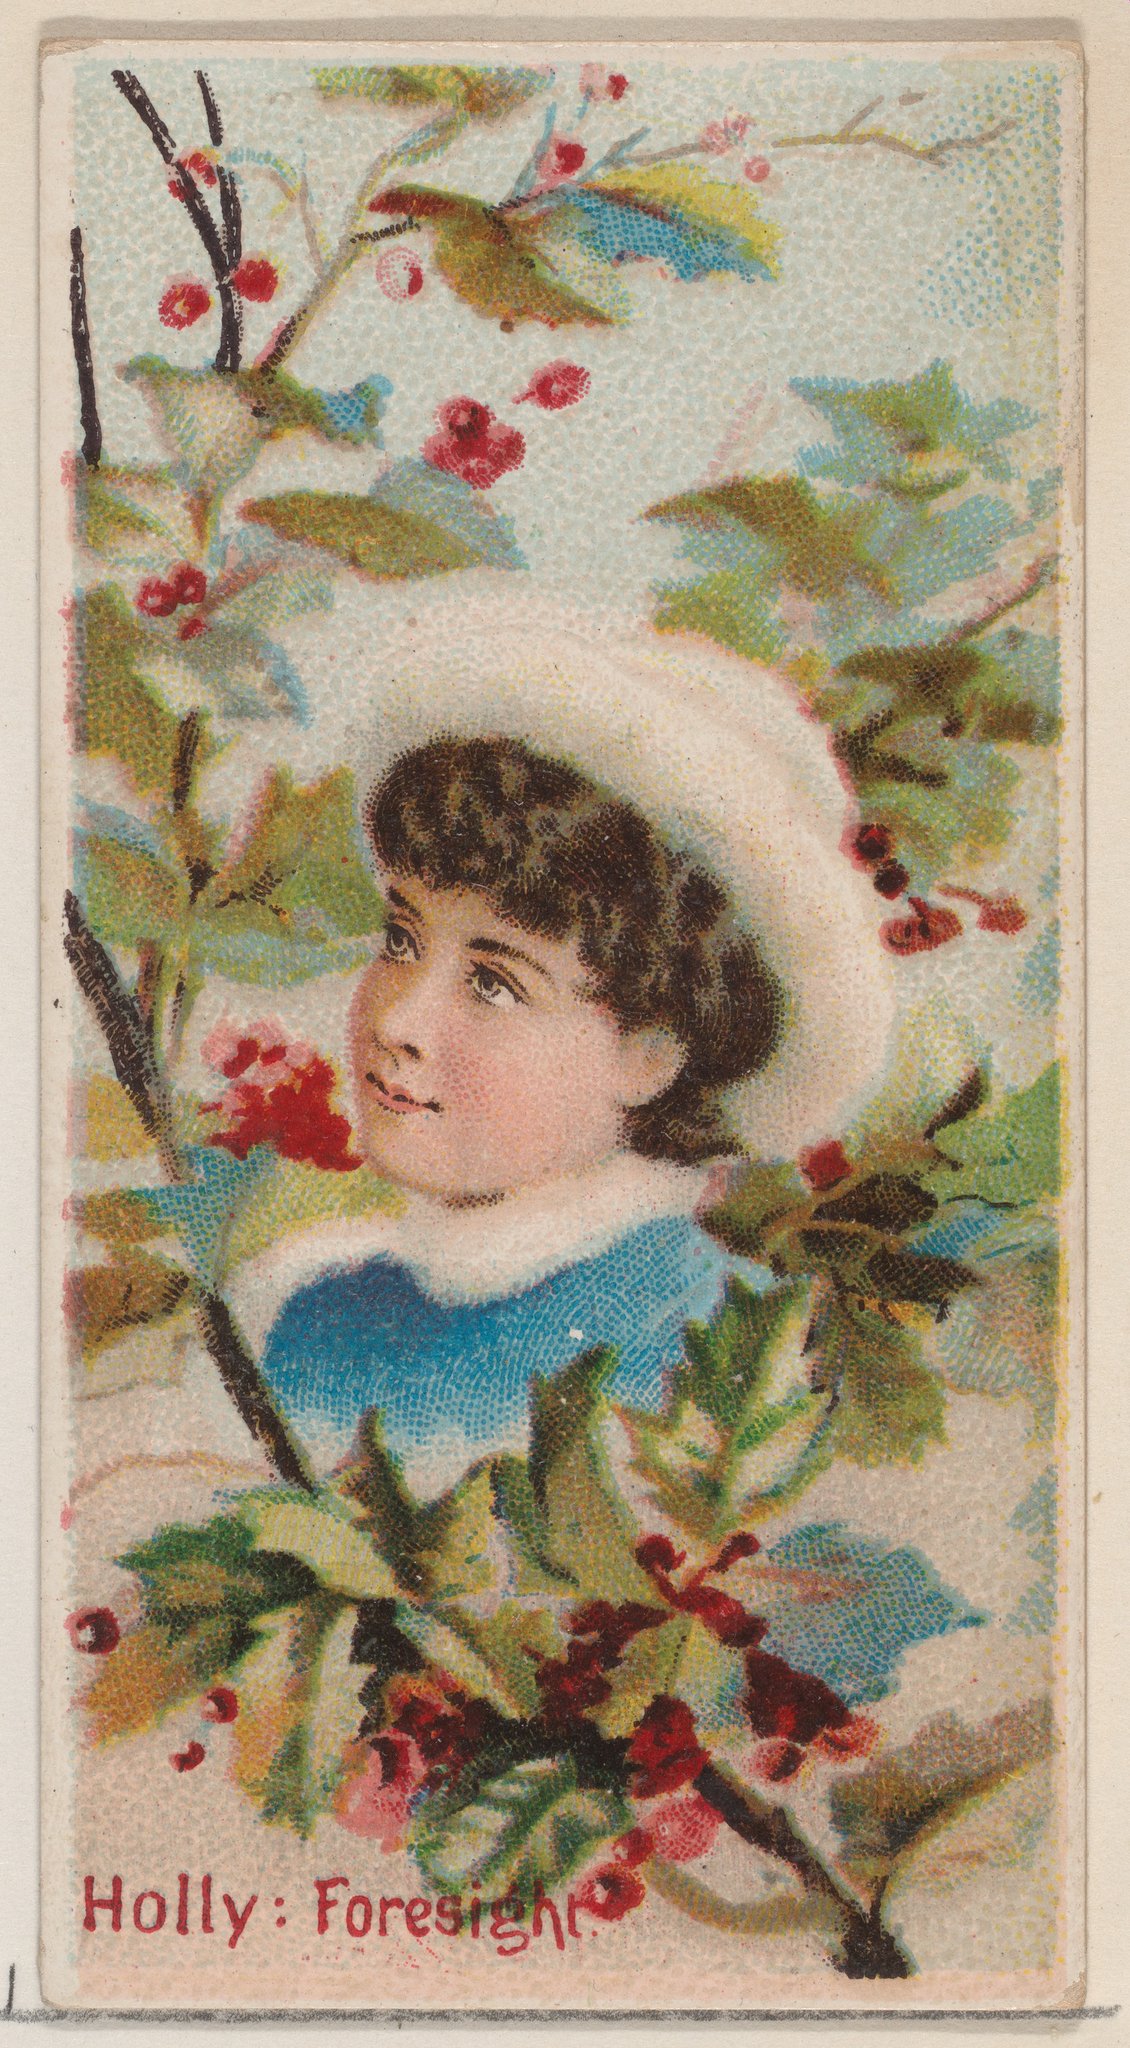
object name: print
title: Holly: Foresight, from the series Floral Beauties and Language of Flowers (N75) for Duke brand cigarettes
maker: american tobacco company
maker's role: publisher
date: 1892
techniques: color lithograph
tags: women,flowers